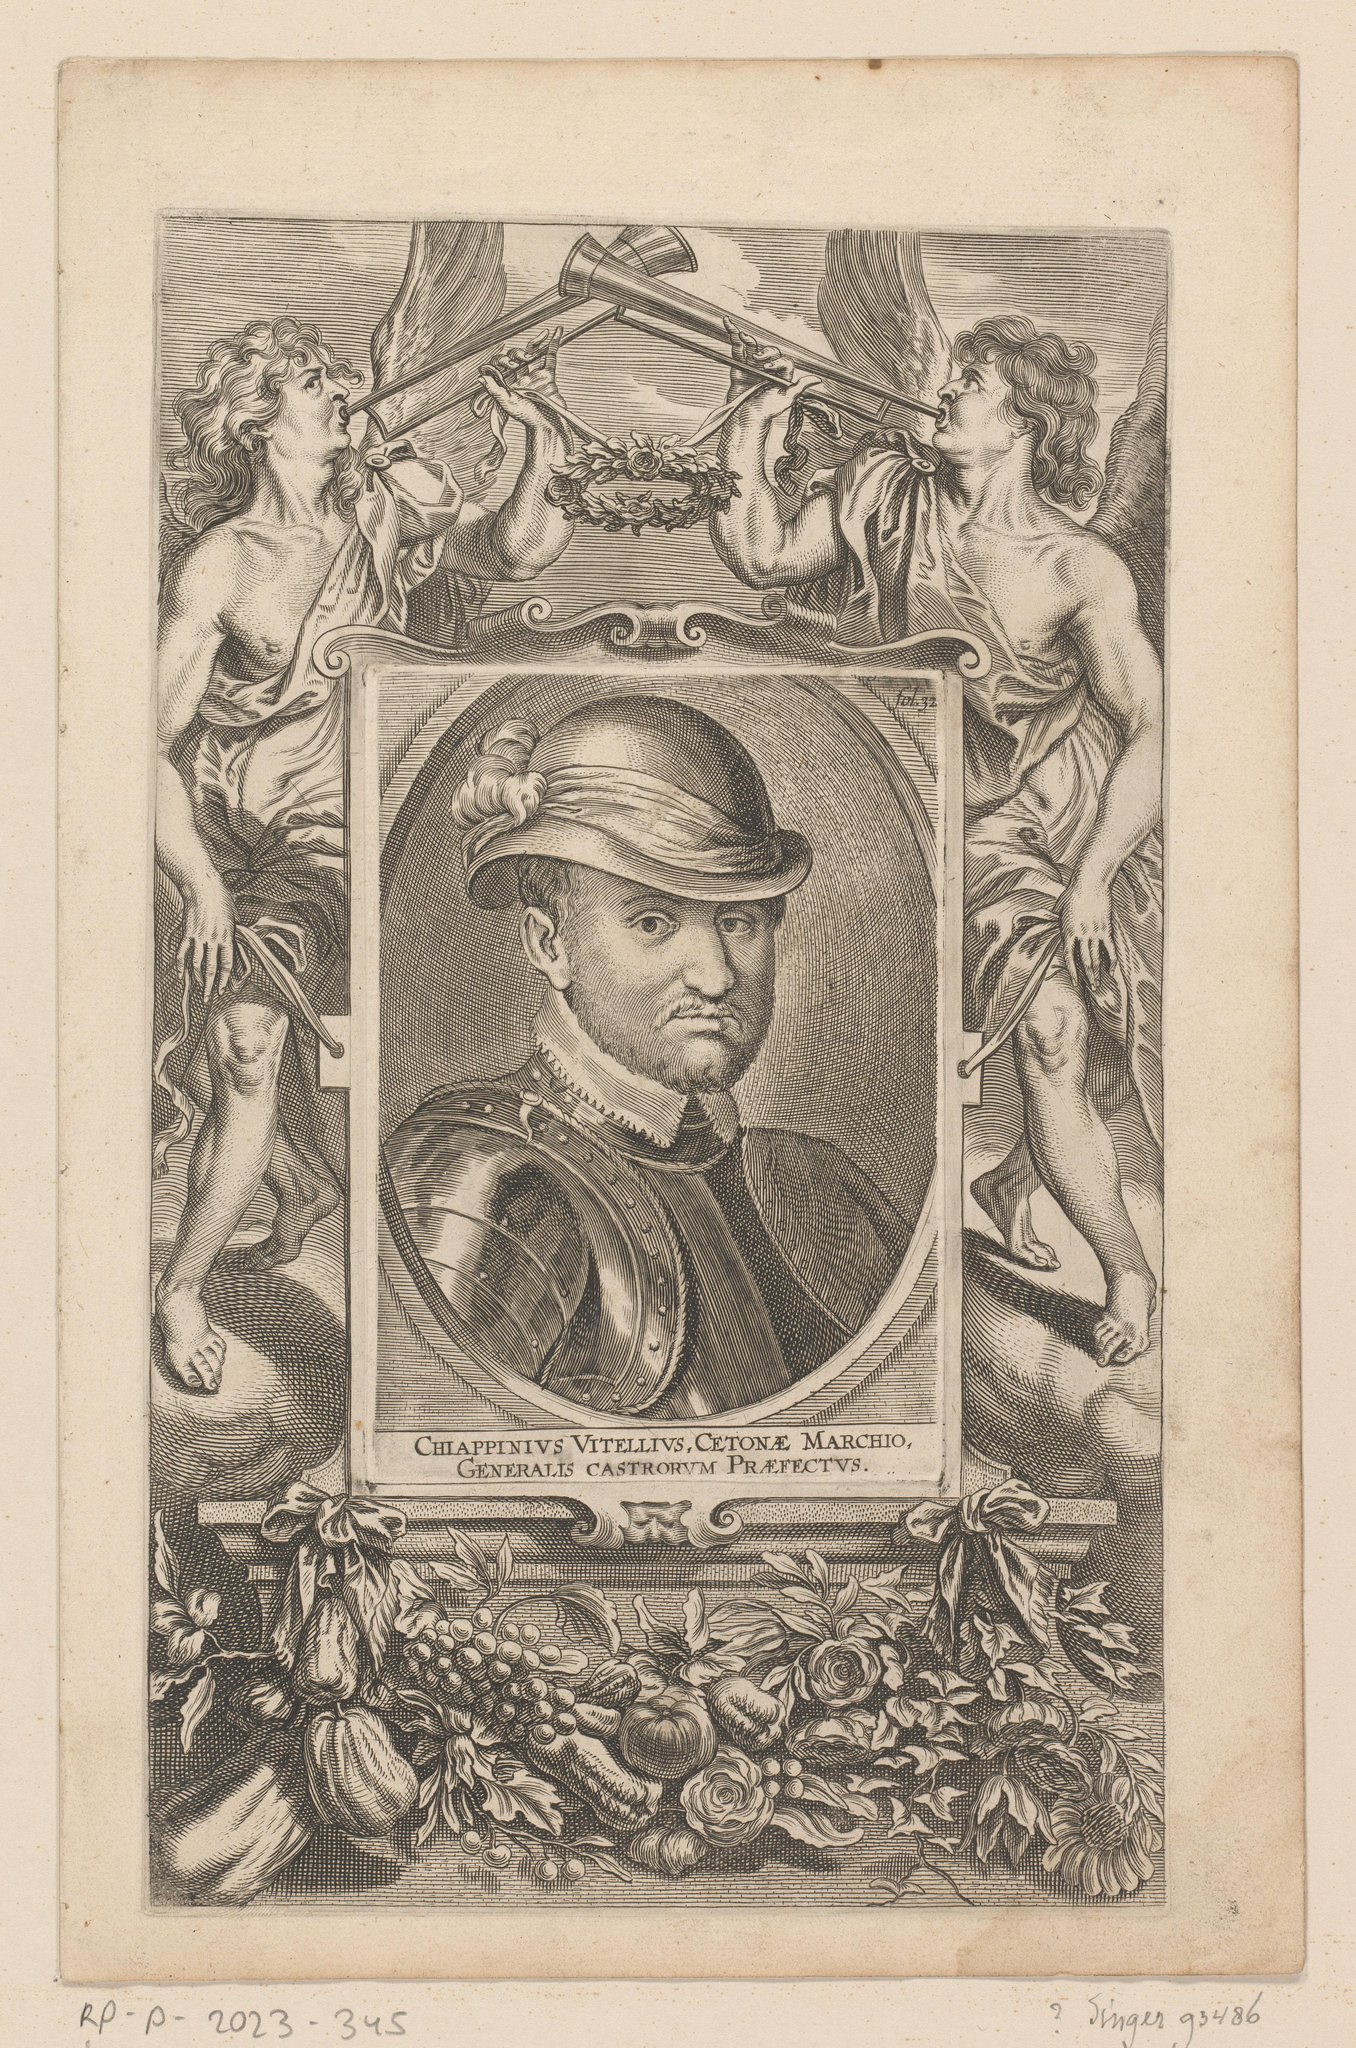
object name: book illustration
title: Portret van Giovan Luigi Vitelli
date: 1640-1699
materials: paper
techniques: engraving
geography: low countries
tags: commander-in-chief, general, marshal, historical persons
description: Portret voor het eerst uitgegeven in: Strada, Famiano. De Bello Belgico. Antwerpen: Jan Cnobbaert, 1640, dl. 1. Huidige staat met vergelijkbare omlijsting komt voor in: Strada, Famiano. De thien eerste boecken der Neder-landtsche oorloghe. Antwerpen: weduwe en erfgenamen Jan Cnobbaert, 1645.